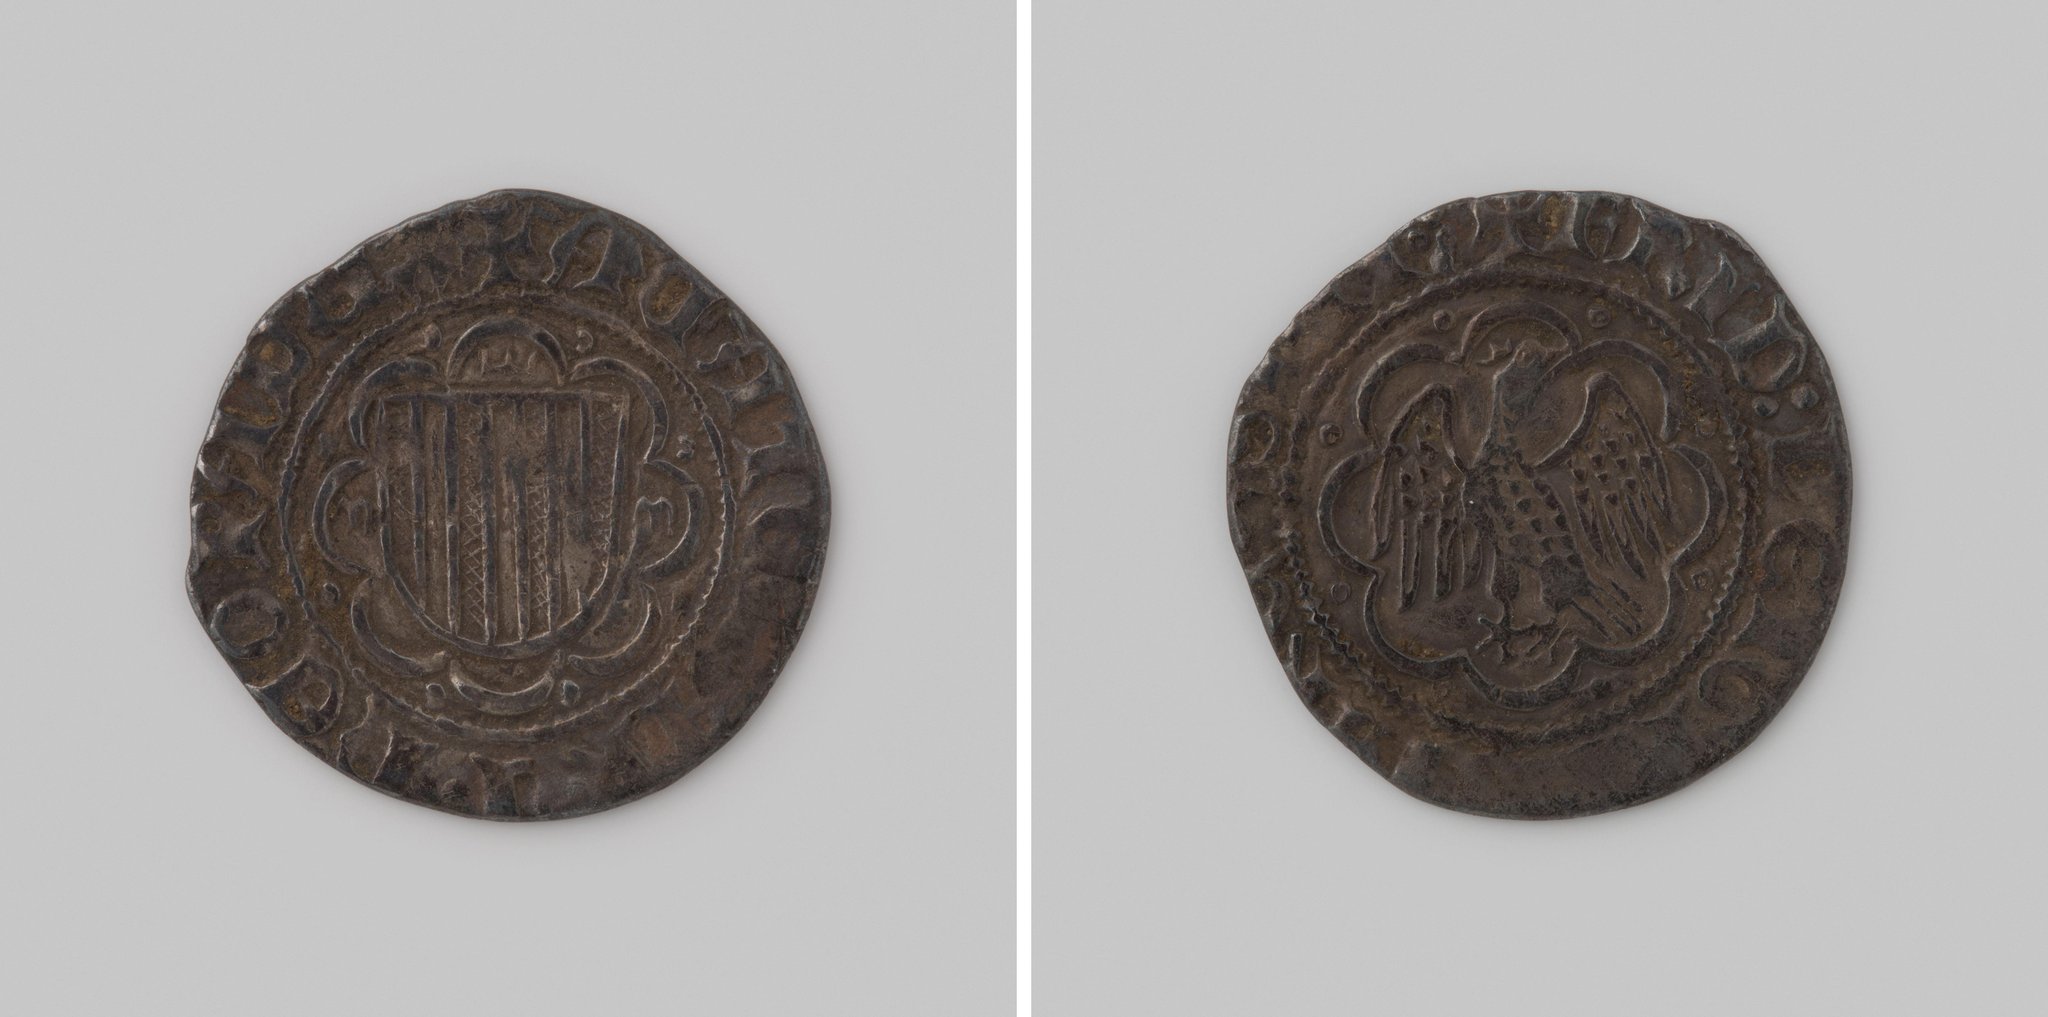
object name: coin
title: Sol coronat uit Sicilië van Frederik III van Aragon, 1296-1337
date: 1296-1337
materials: silver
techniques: striking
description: Zilveren munt. Voorzijde: binnen een veelpas het wapenschild van Aragon. Keerzijde: binnen een vierpas omkijkende adelaar met gespreide vleugels.